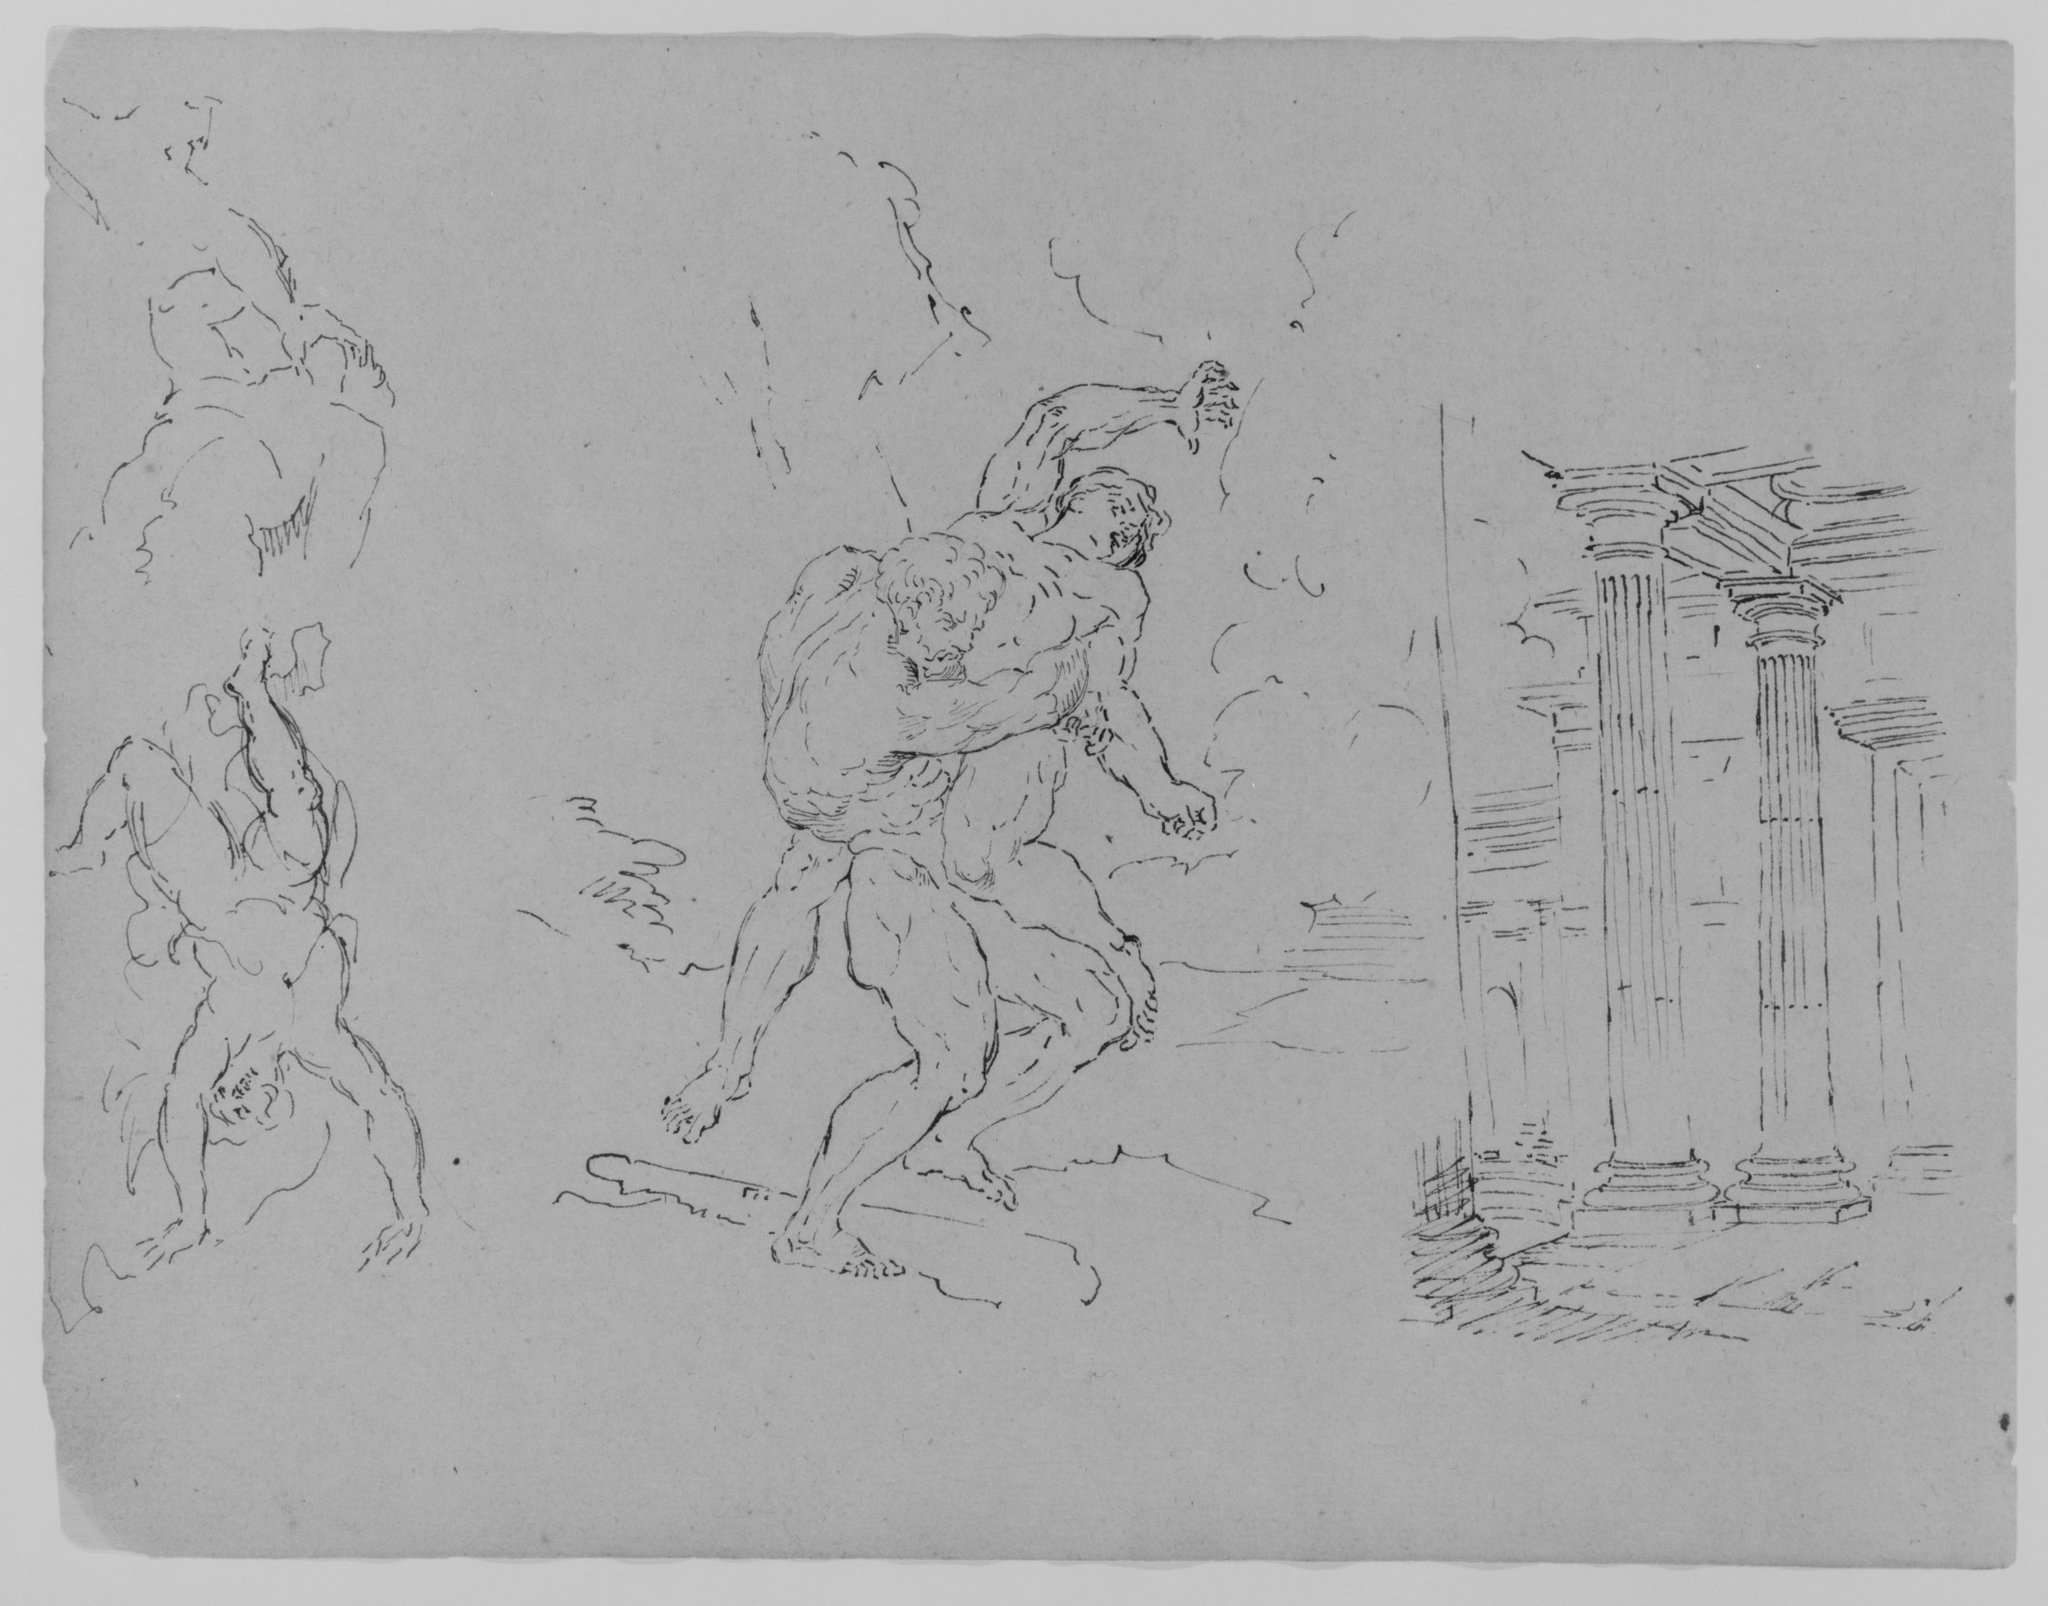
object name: drawing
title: Hercules and Antoneus; Fall of Phaetor (Icarus?); Classical Architecture; Sacrifice of Isaac [?] (after Rembrandt?) (from Sketchbook)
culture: american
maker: thomas sully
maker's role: artist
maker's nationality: american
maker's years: 1783-1872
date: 1810-1820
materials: ink, paper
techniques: wash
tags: men,hercules